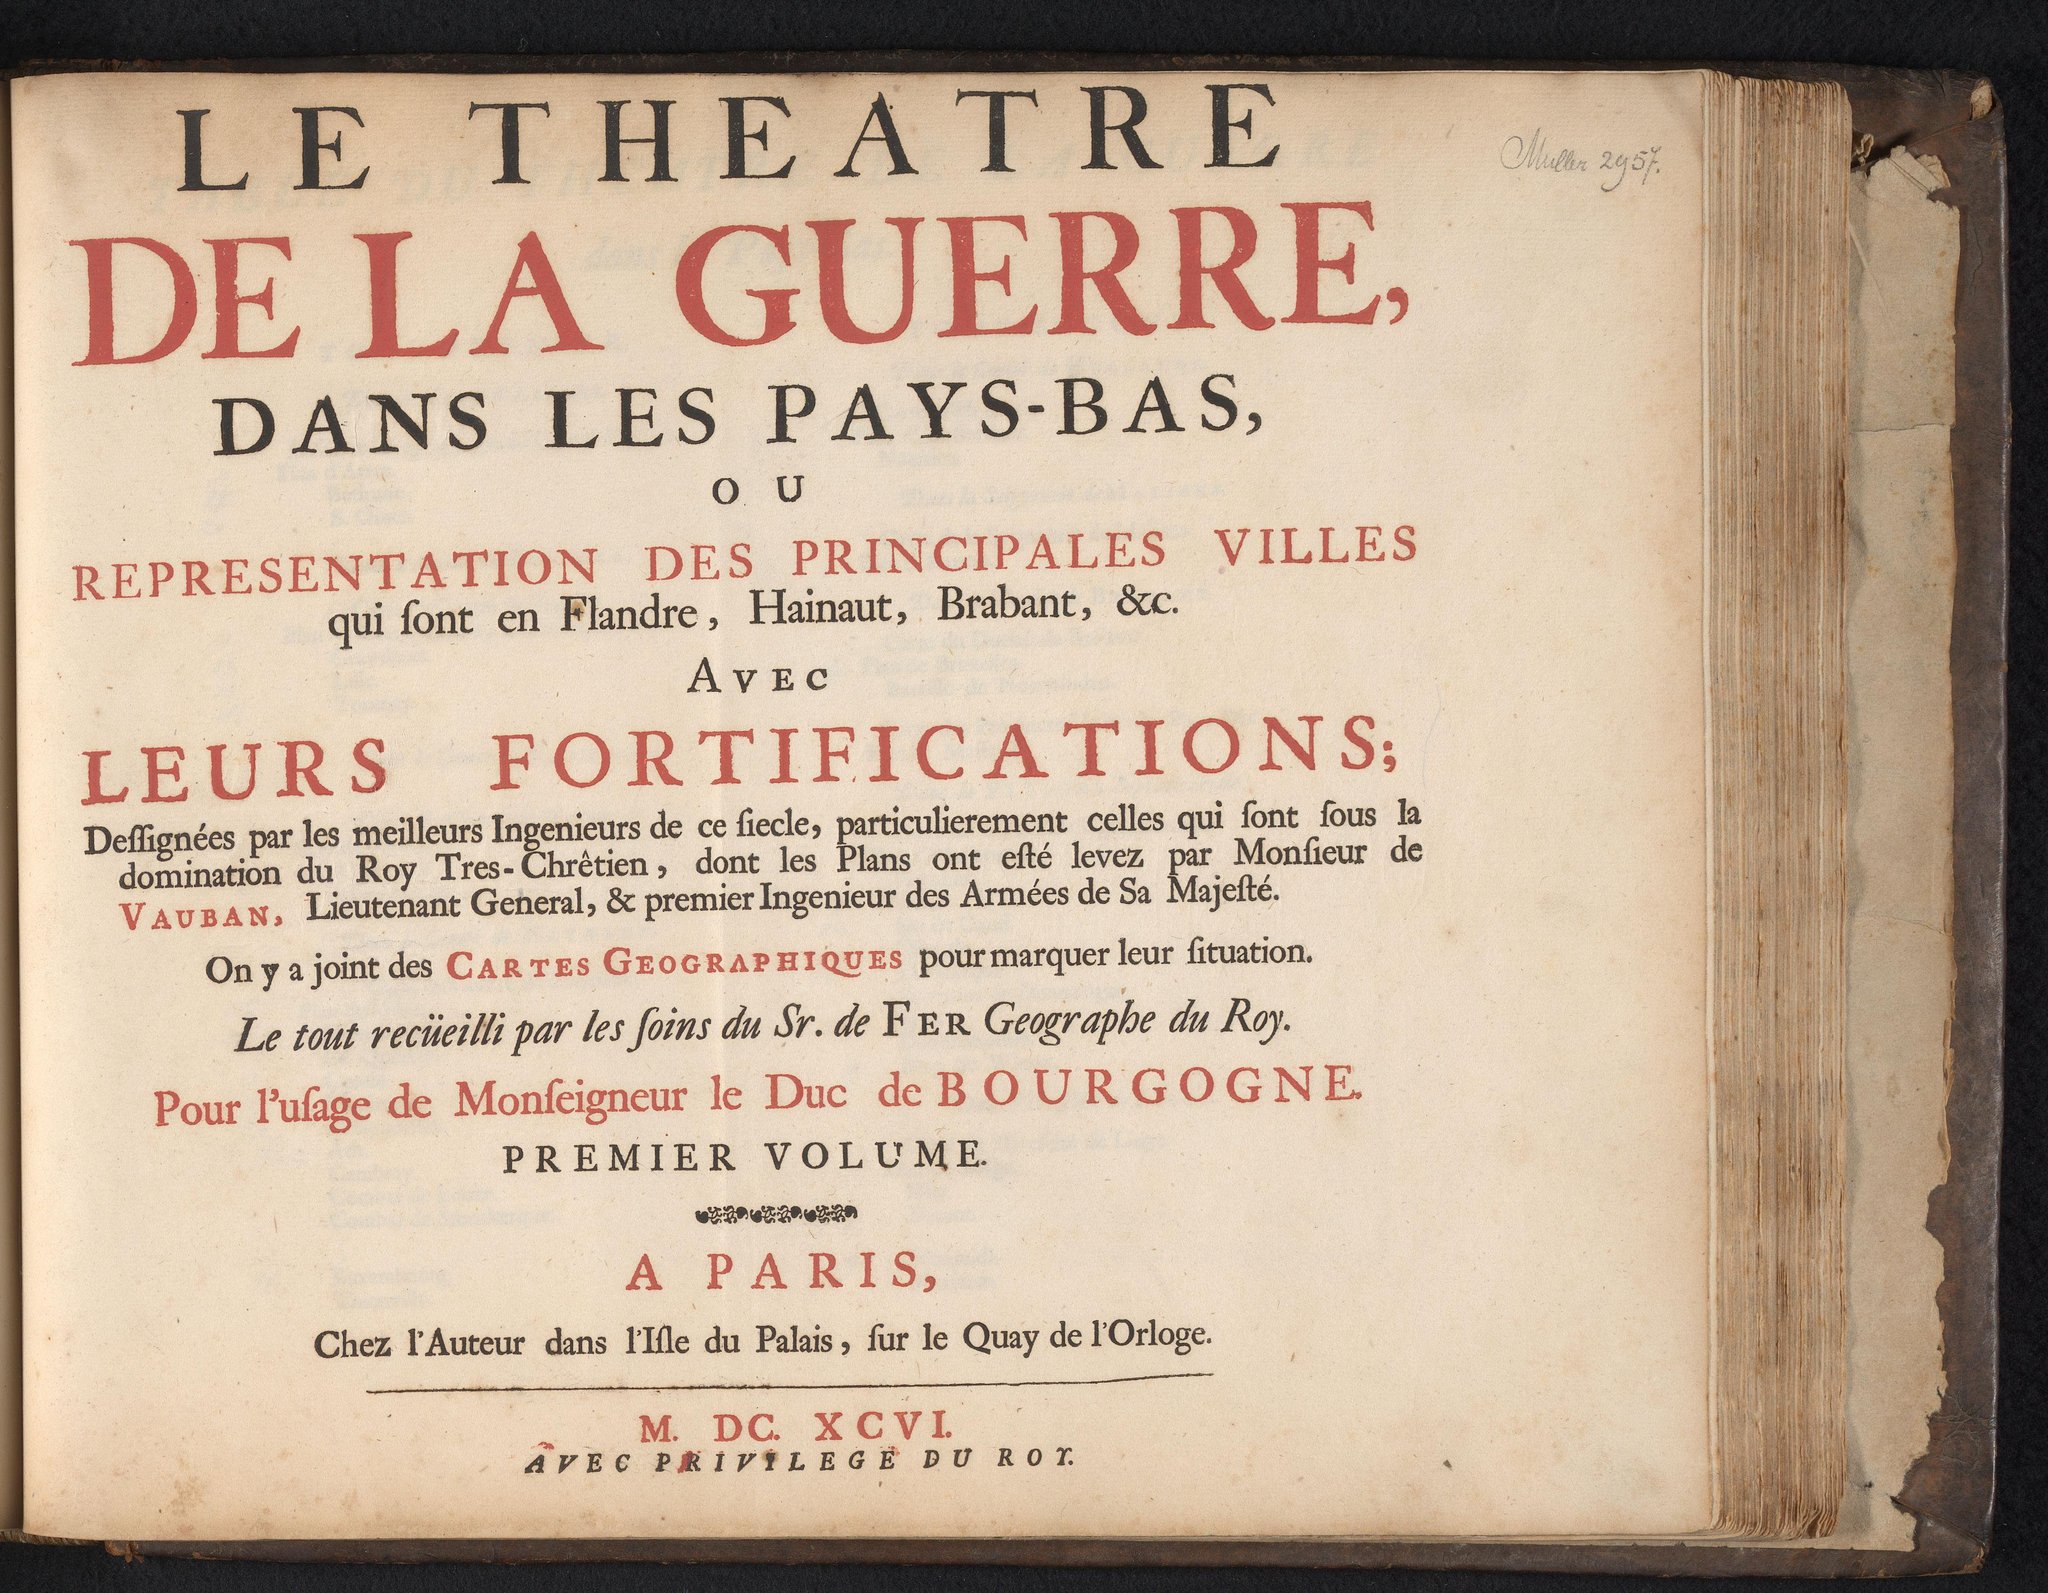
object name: titelblad, titelpagina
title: Le theatre de la guerre, dans les Pays-Bas, ou representation des principales villes qui sont en Flandre, Hainaut, Brabant, et c. : avec leurs fortifications : dessignées par les meilleurs ingenieurs, particulierement celles (...) dont les plans ont esté levez par M. de Vauban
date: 1696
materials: paper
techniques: letterpress printing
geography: paris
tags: negenjarige oorlog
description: Titelpagina uit 1696 gedrukt in zwart en rood voor het eerste van twee delen van het prentwerk: Le Theatre de la Guerre, dans les Pays-Bas, uitgegeven in 1696. Het prentwerk bestaat in totaal (beide delen) uit 52 platen met plannen (afkomstig van Sébastien Le Prestre, Seigneur de Vauban) van vermaarde sterke steden en vestingen in de Negenjarige Oorlog in de Nederlanden. Titel in het Frans.